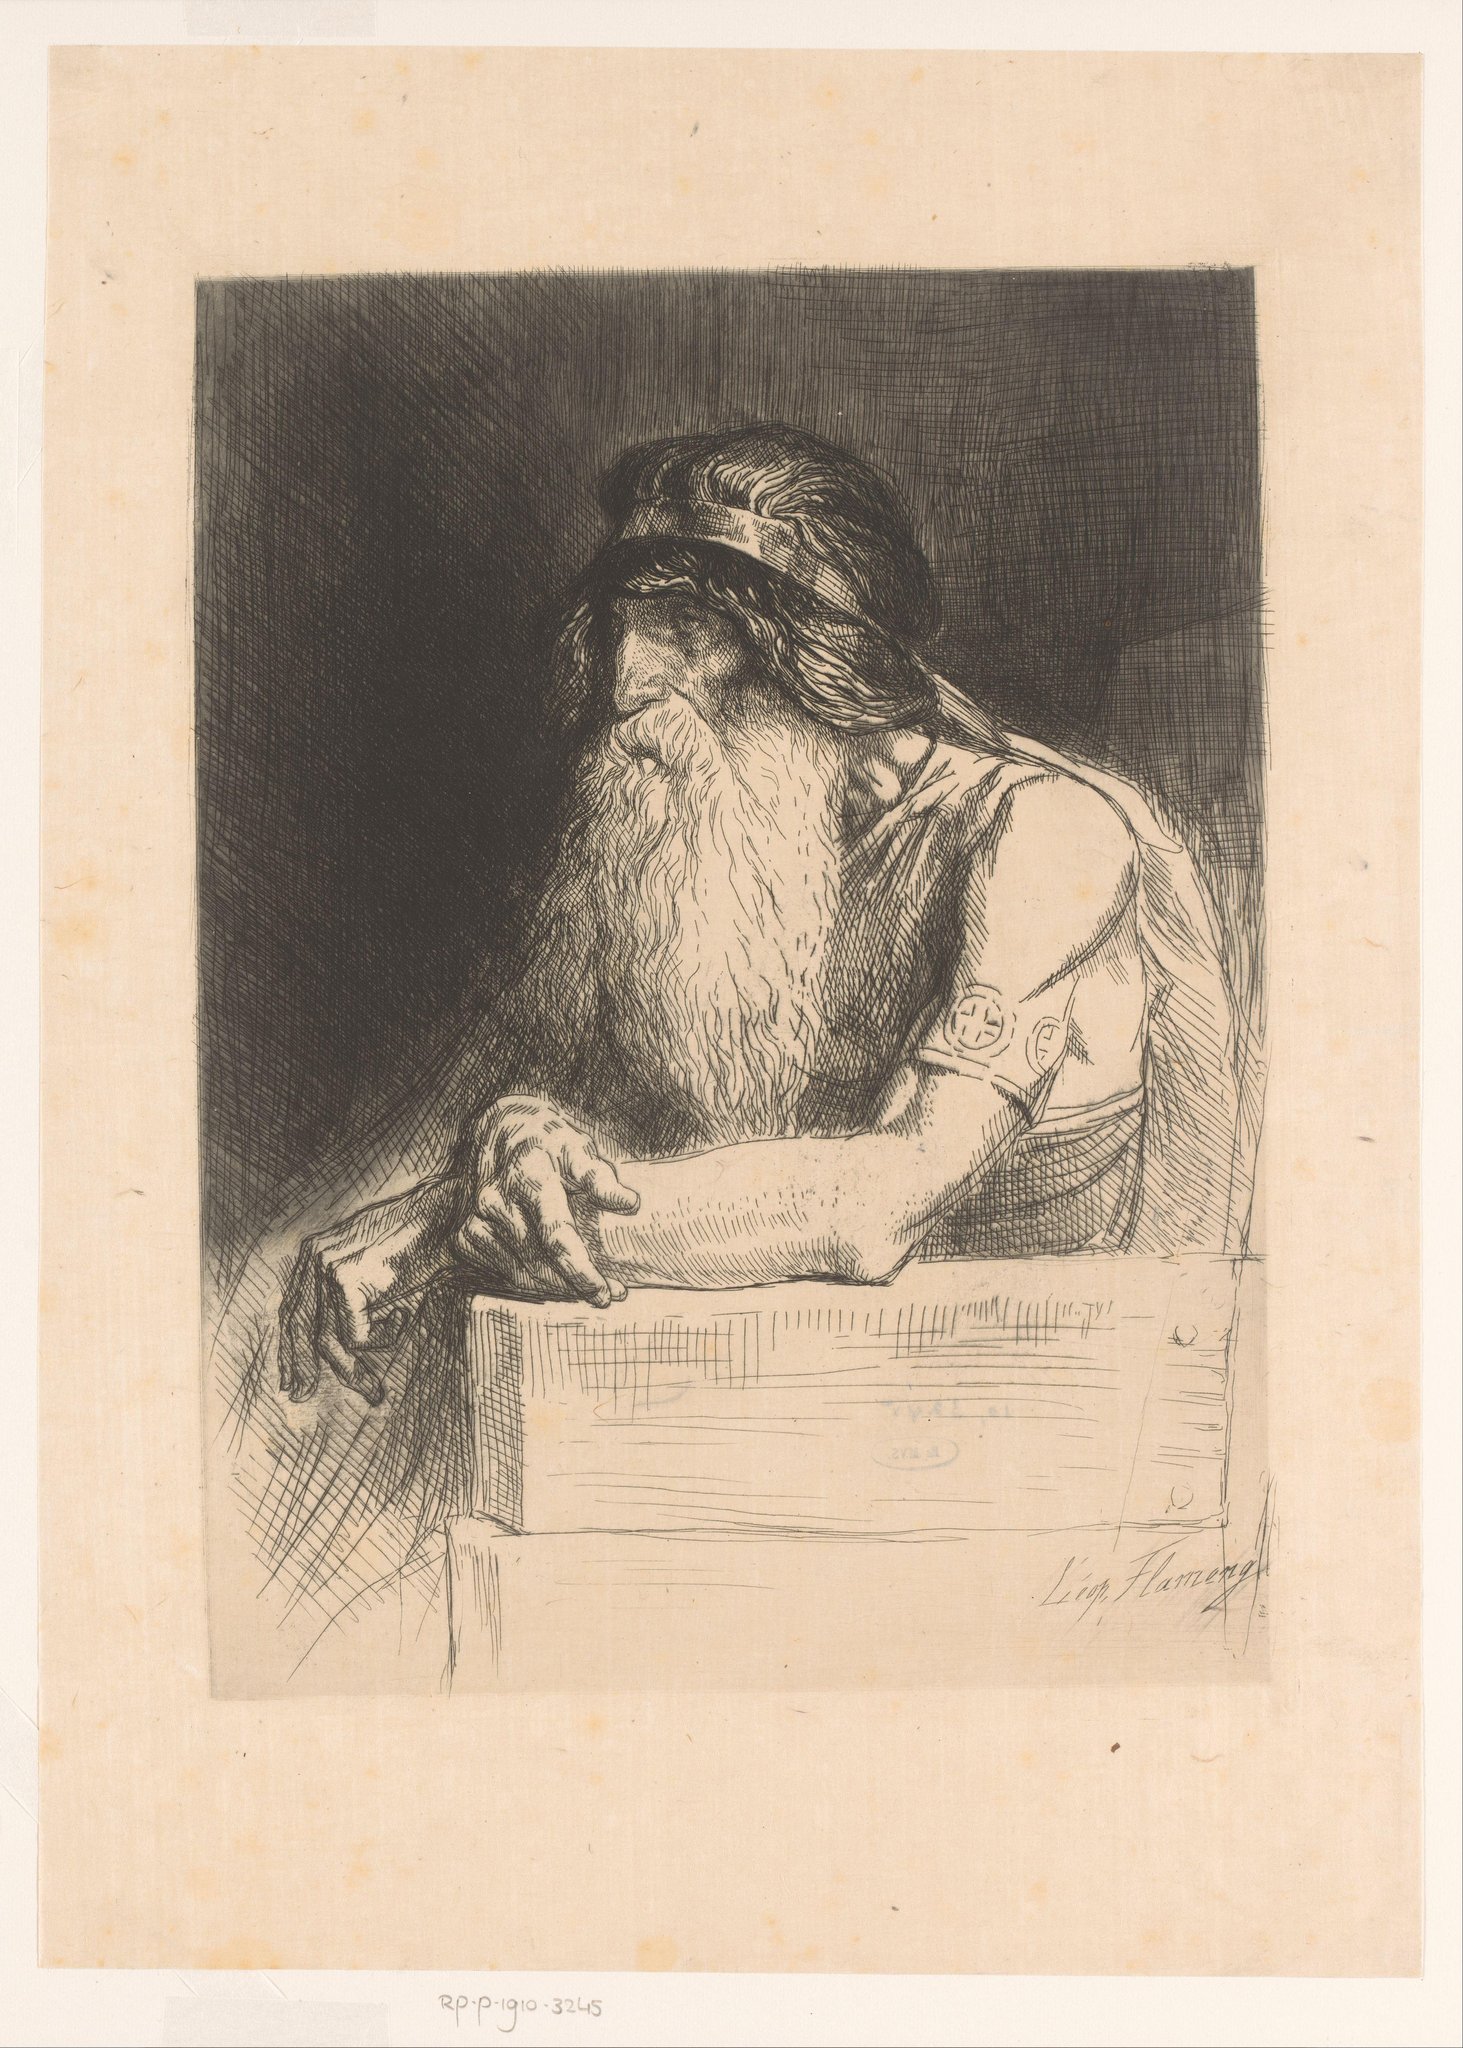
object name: print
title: Oude man met de armen gekruist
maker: léopold flameng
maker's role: print maker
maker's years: 1831-1911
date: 1841-1910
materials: paper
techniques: drypoint, etching, intaglio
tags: old man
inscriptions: collector's mark: Lugt 2228